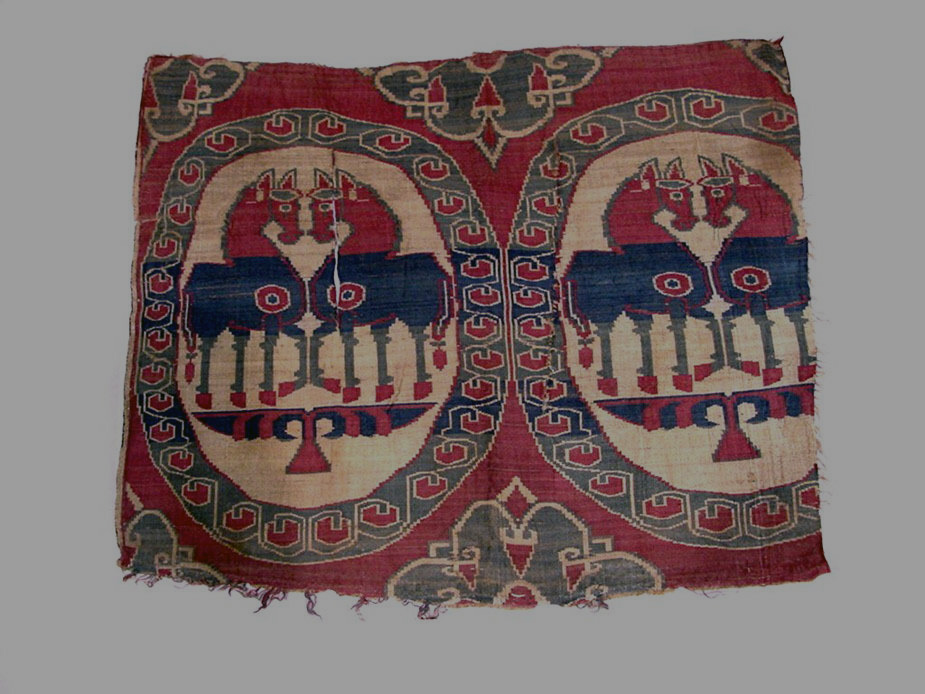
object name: piece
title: Textile with Confronted Horses in Roundels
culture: central asian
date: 701-900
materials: silk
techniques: weave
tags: horses